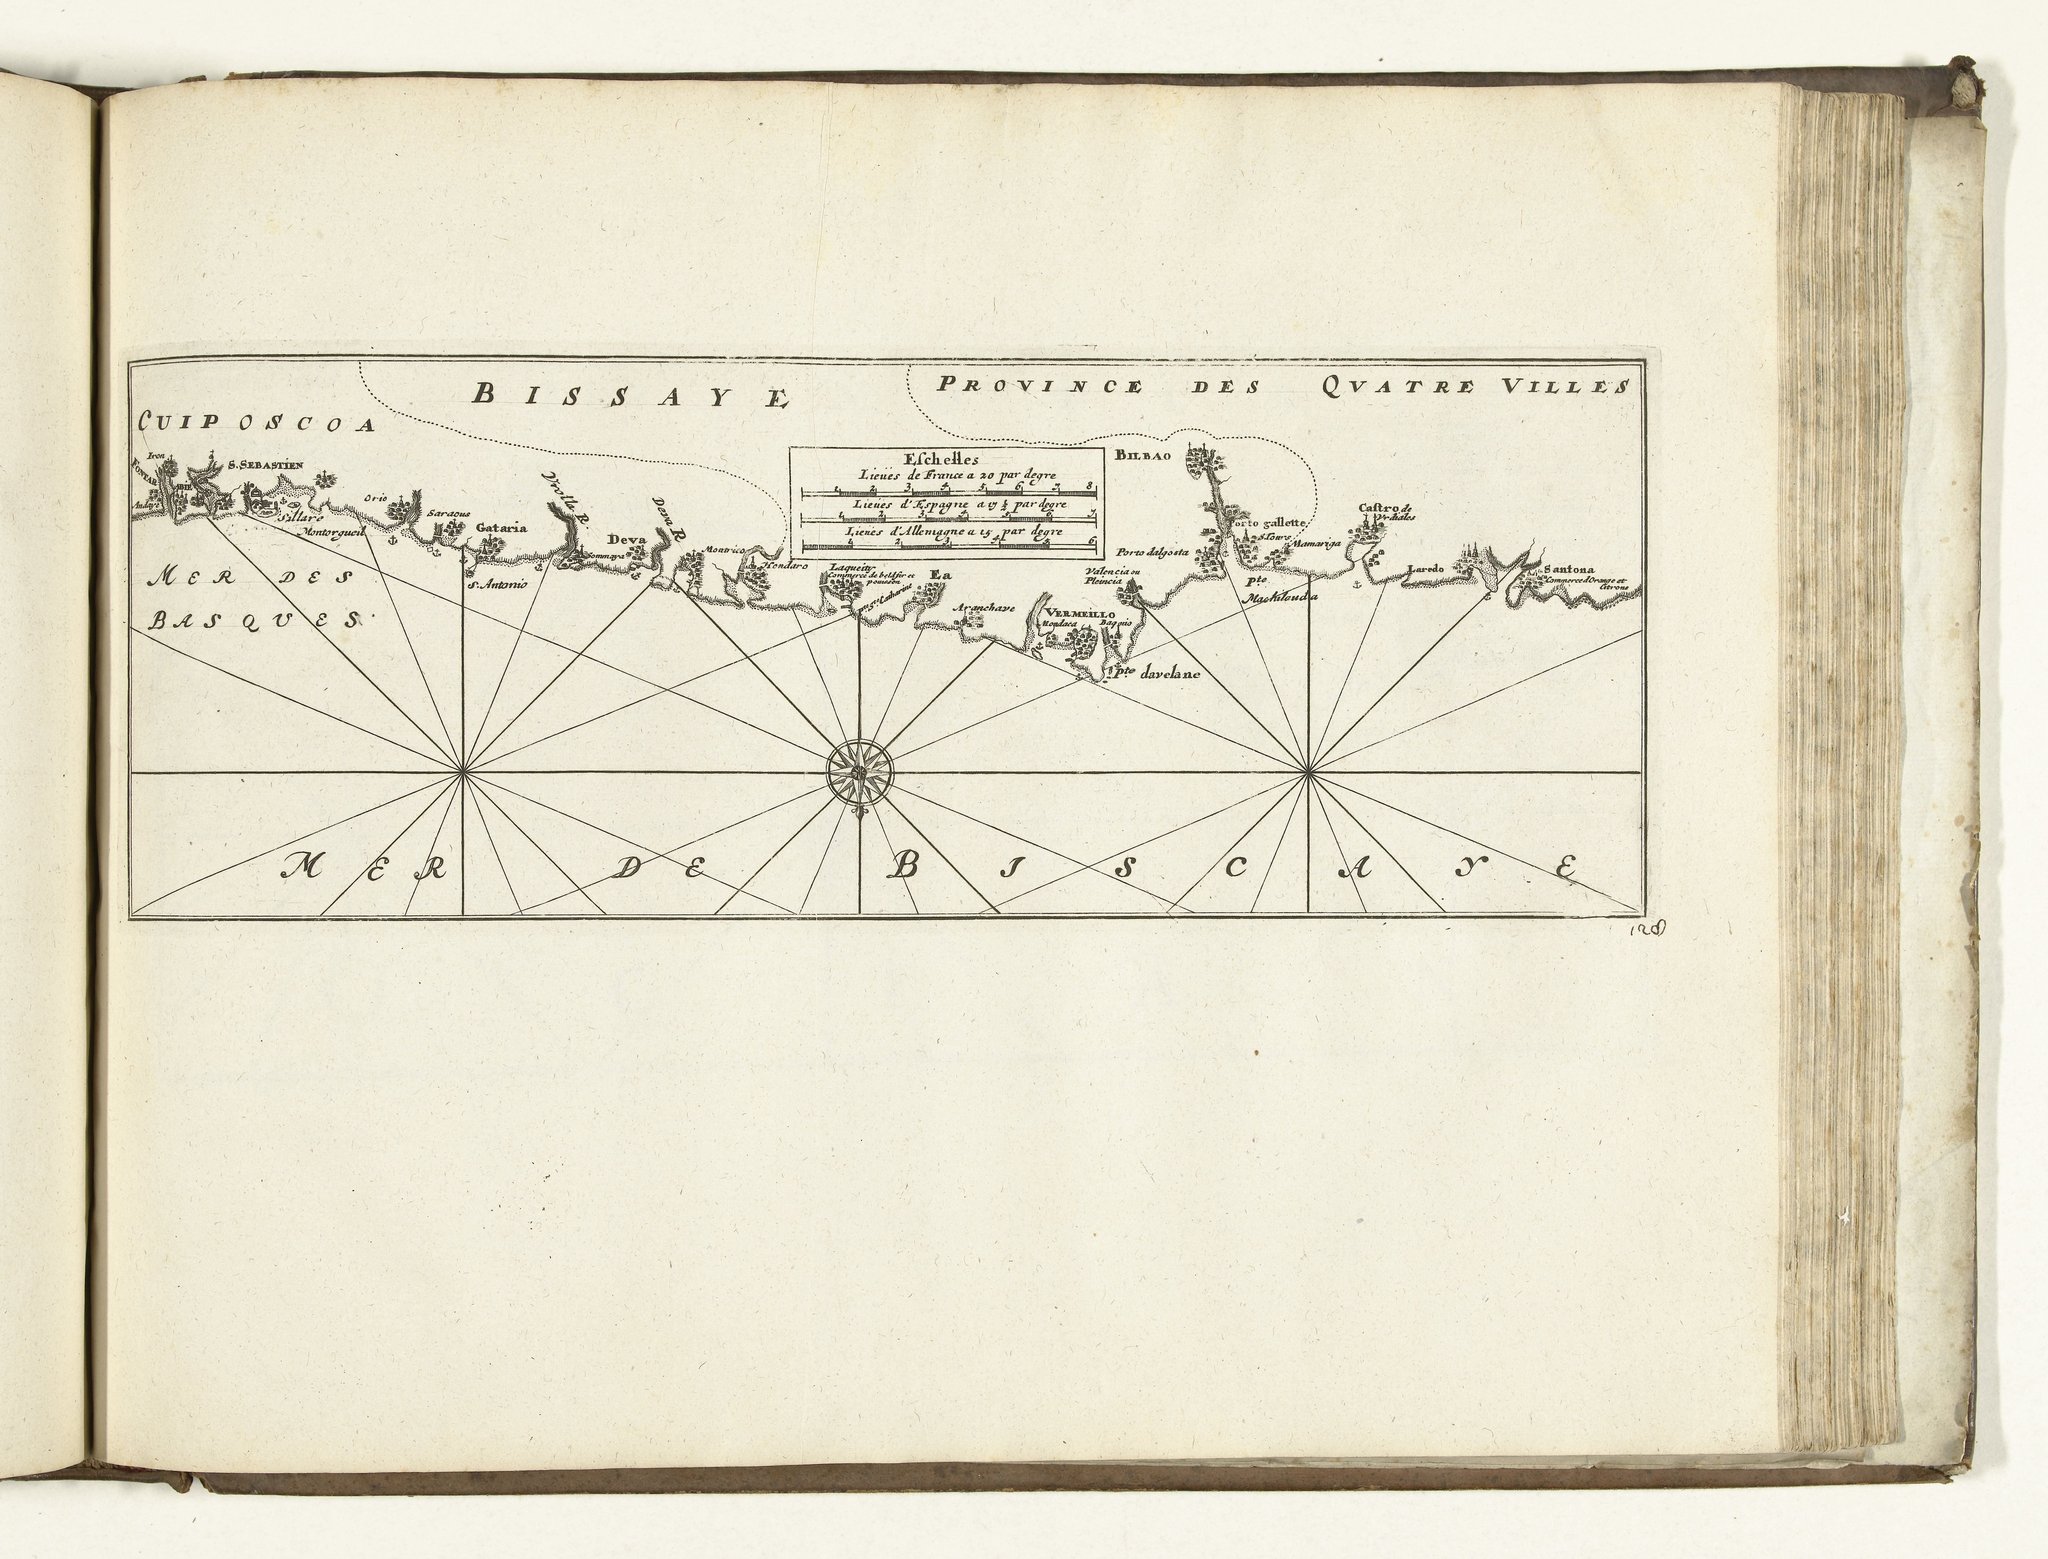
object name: print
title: Les Forces de l'Europe, Asie, Afrique et Amerique (...) Comme aussi les Cartes des Côtes de France et d'Espagne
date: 1726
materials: paper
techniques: etching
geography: leiden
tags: maps of separate countries or regions, spain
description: Kaart van de Spaanse noordkust tussen Bilbao en San Sebastián. Plaat nr. 128 in deel VI van het prentwerk: Les Forces de l'Europe, Asie, Afrique et Amerique ... Comme aussi les Cartes des Côtes de France et d'Espagne uit 1726, dit eerste deel met 238 met de hand genummerde platen van vermaarde sterke steden en vestingen in het kader van de Spaanse Successieoorlog 1701-1713. Voor het merendeel zijn deze platen gekopieerd naar de anonieme Franse platen van vermaarde sterke steden en vestingen: in Les forces de l'Europe en in: Le theatre de la guerre, dans les Pays-Bas, beide oorspronkelijk uitgegeven door Nicolas de Fer te Parijs (1693-1697) in het kader van de Negenjarige Oorlog. Opschriften in het Frans.